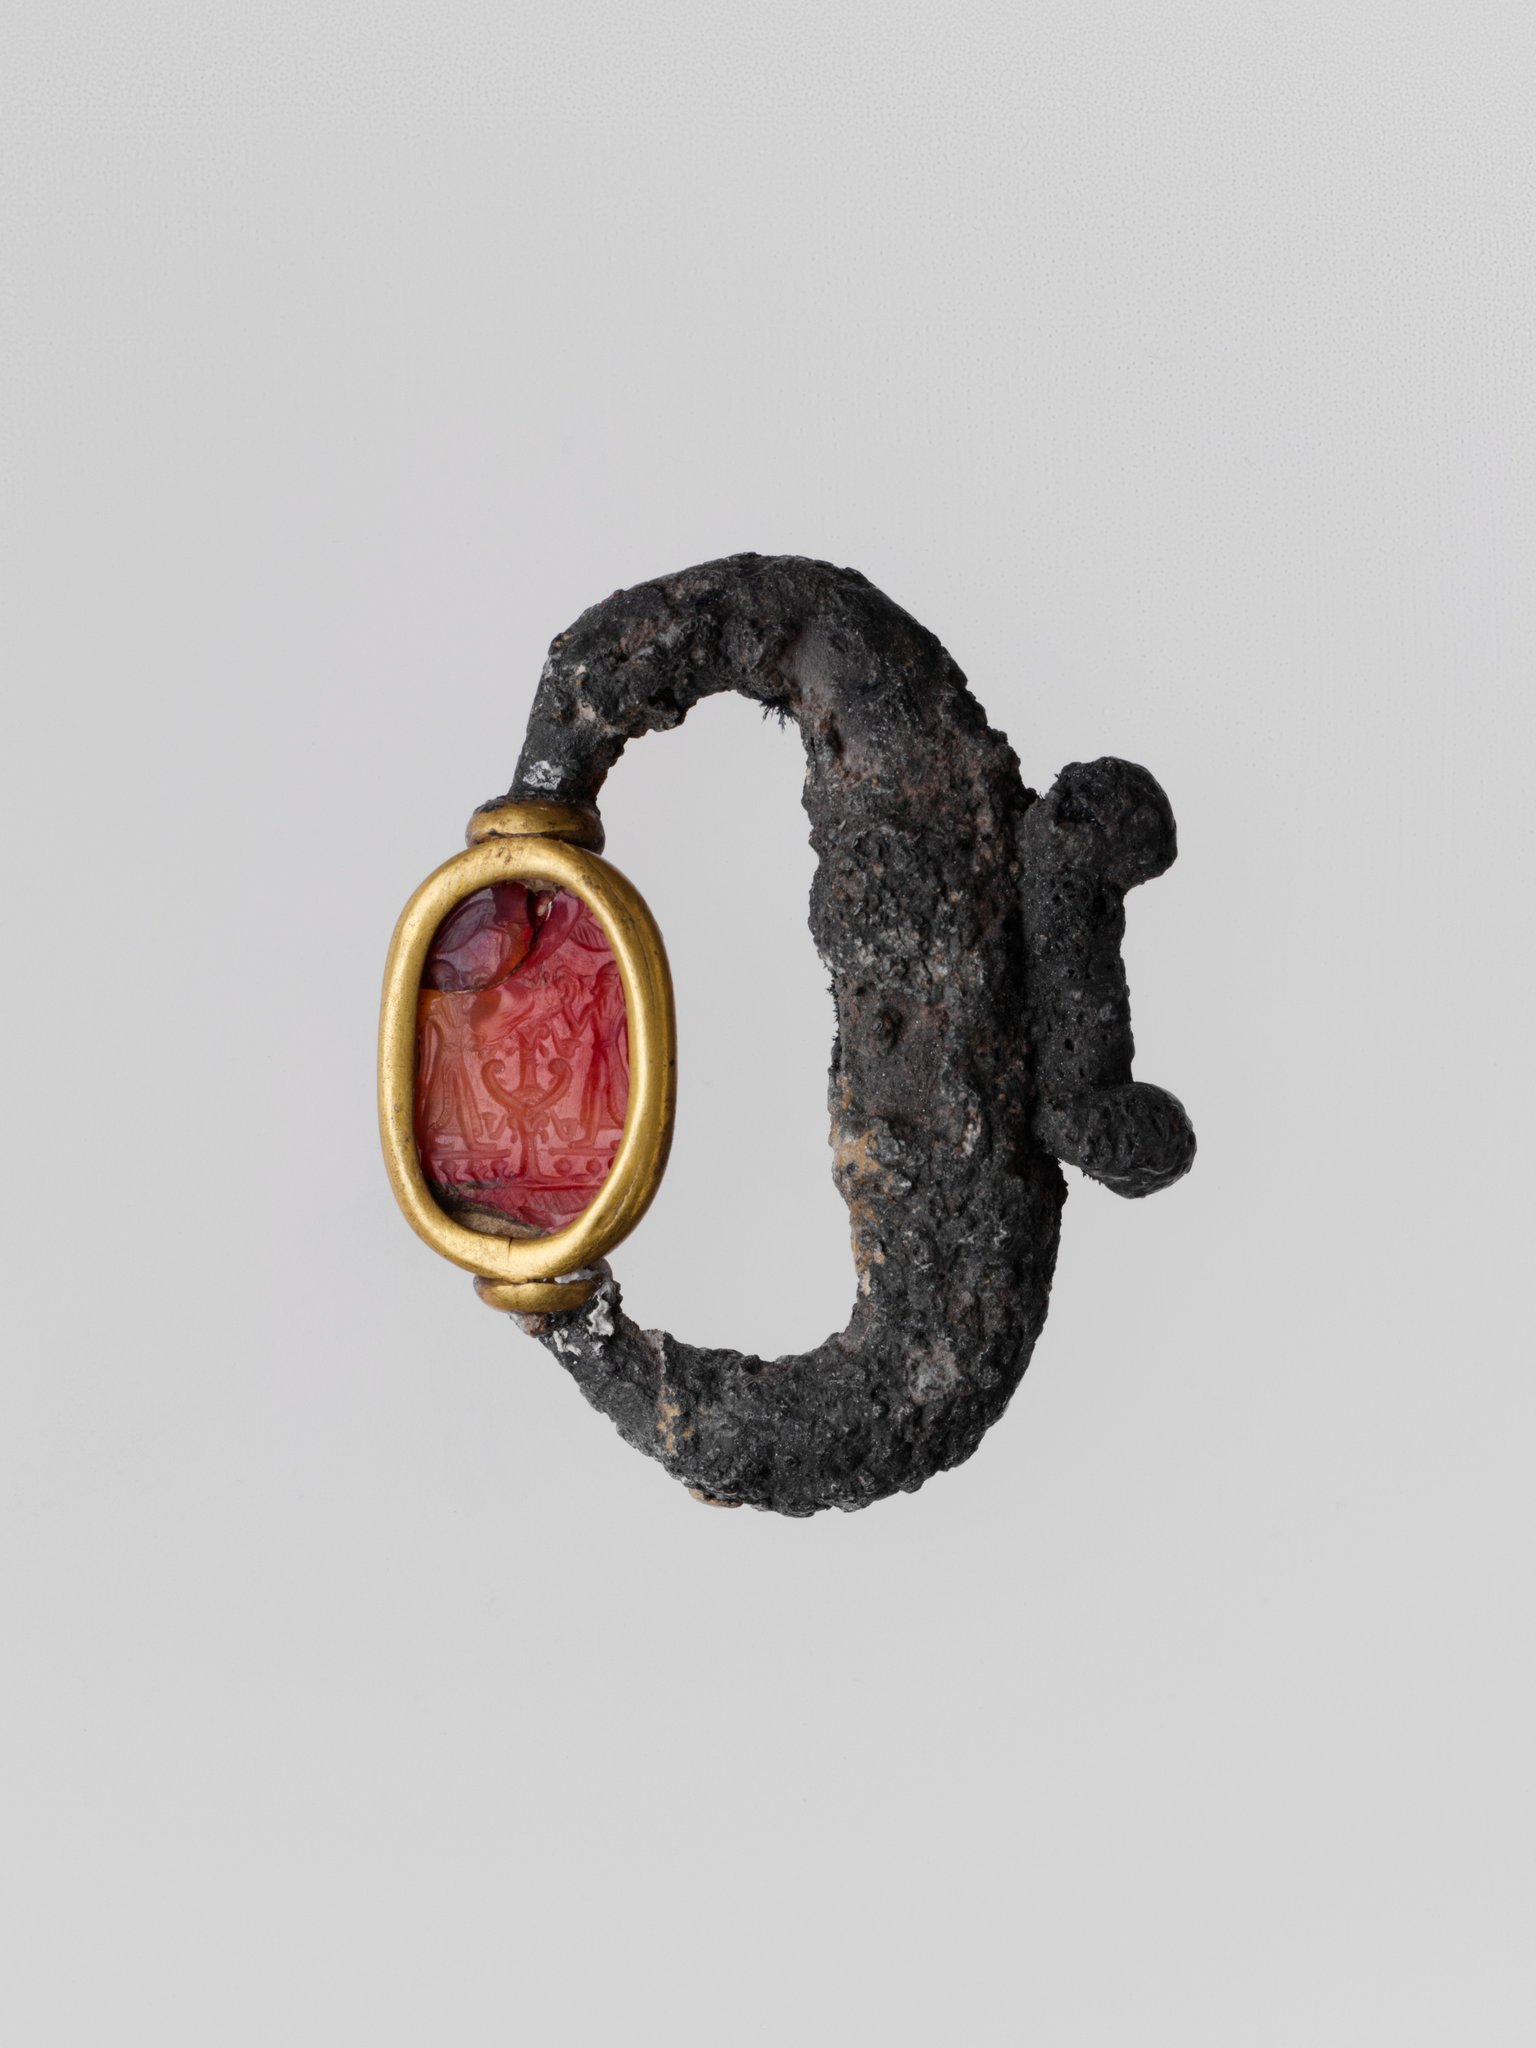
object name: ring with scarab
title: Silver pendant with carnelian scarab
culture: cypriot or phoenician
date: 600-401 BCE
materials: gemstone, silver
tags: men